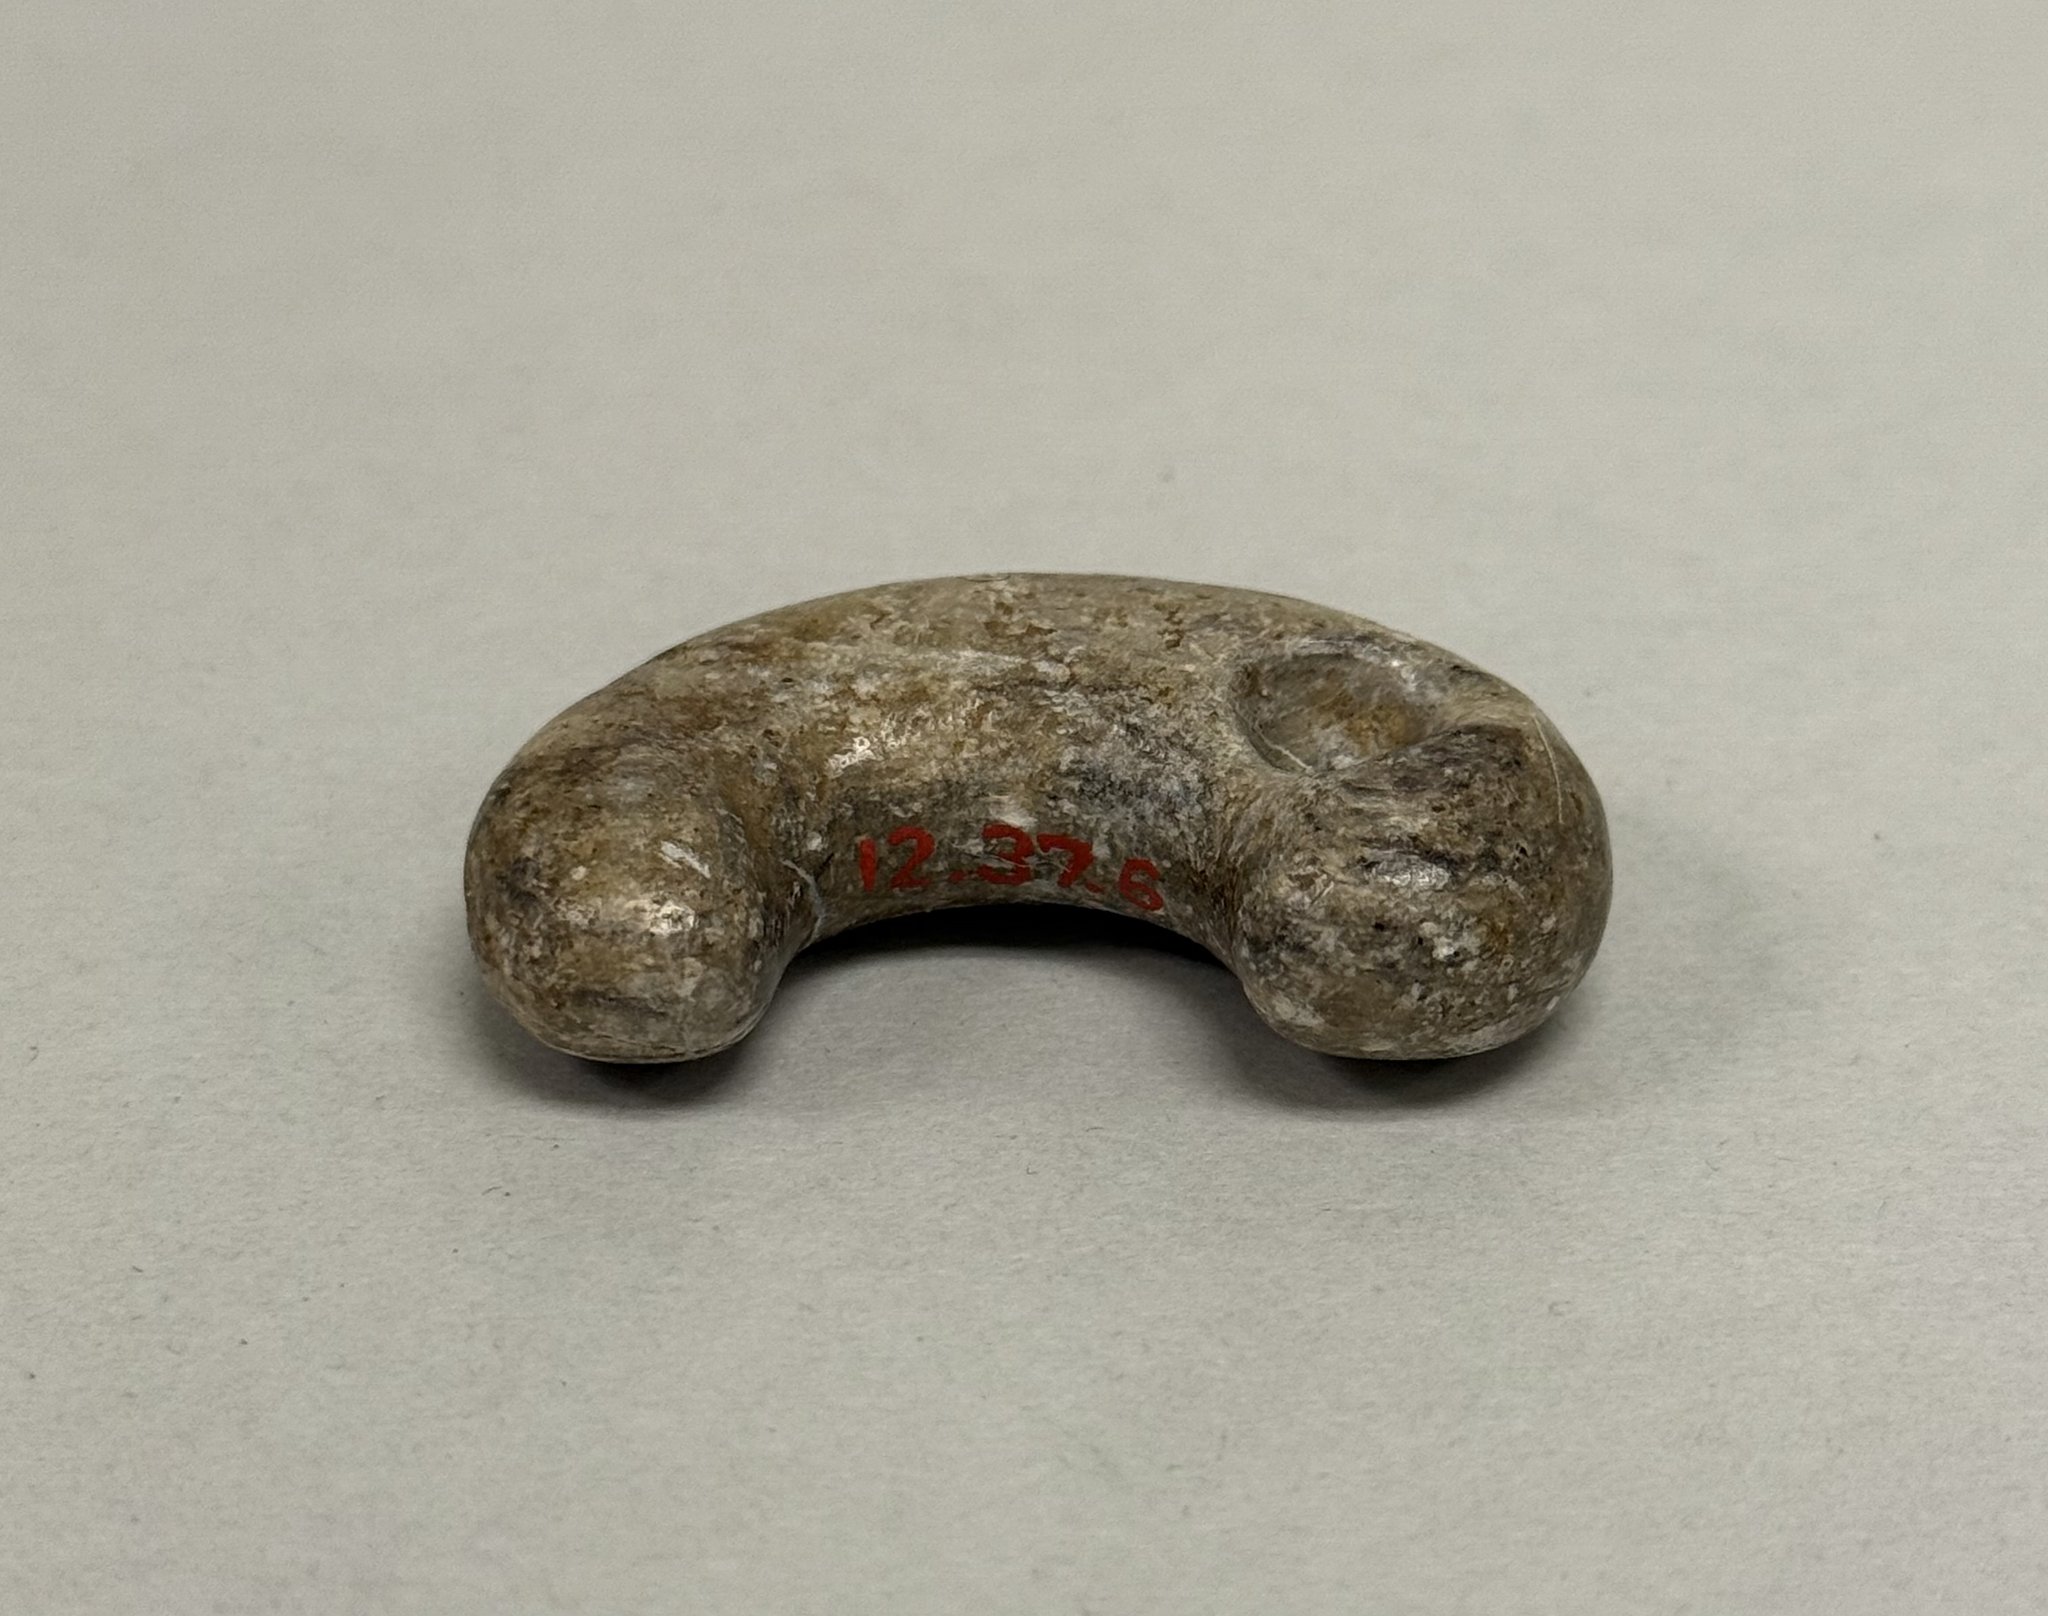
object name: jewel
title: Tiger Claw Jewel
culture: japanese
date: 601-700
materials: stone